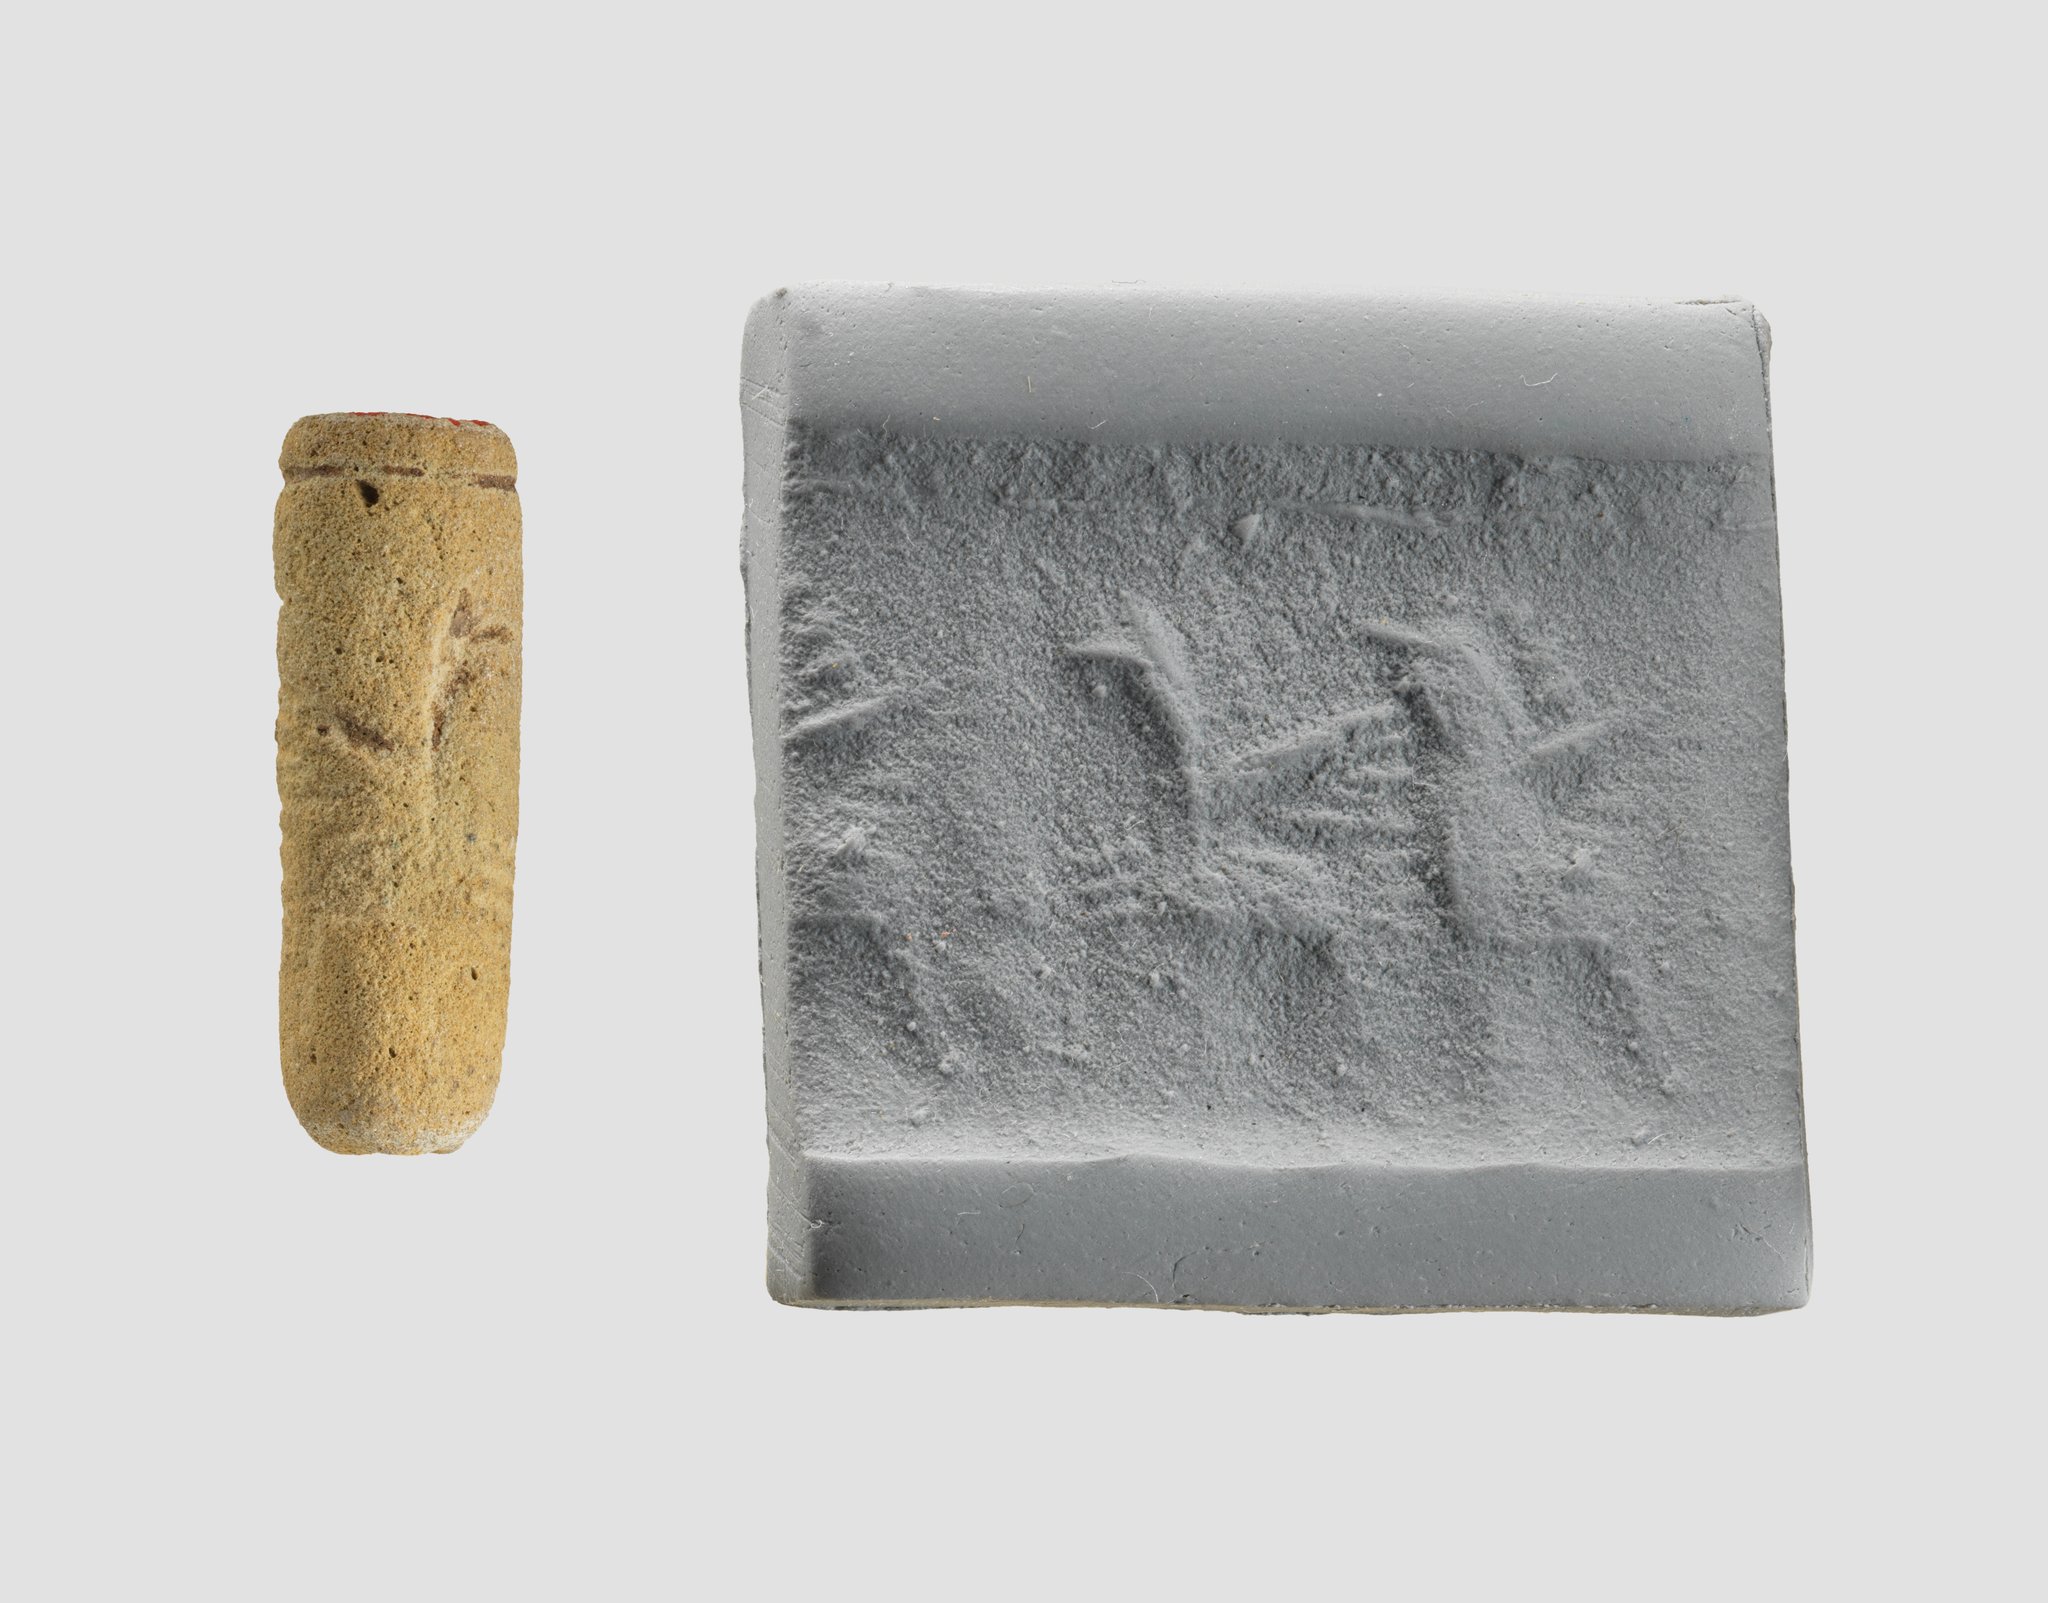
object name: cylinder seal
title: Cylinder seal with monsters or animals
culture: assyrian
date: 800-601 BCE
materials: faience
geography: iran